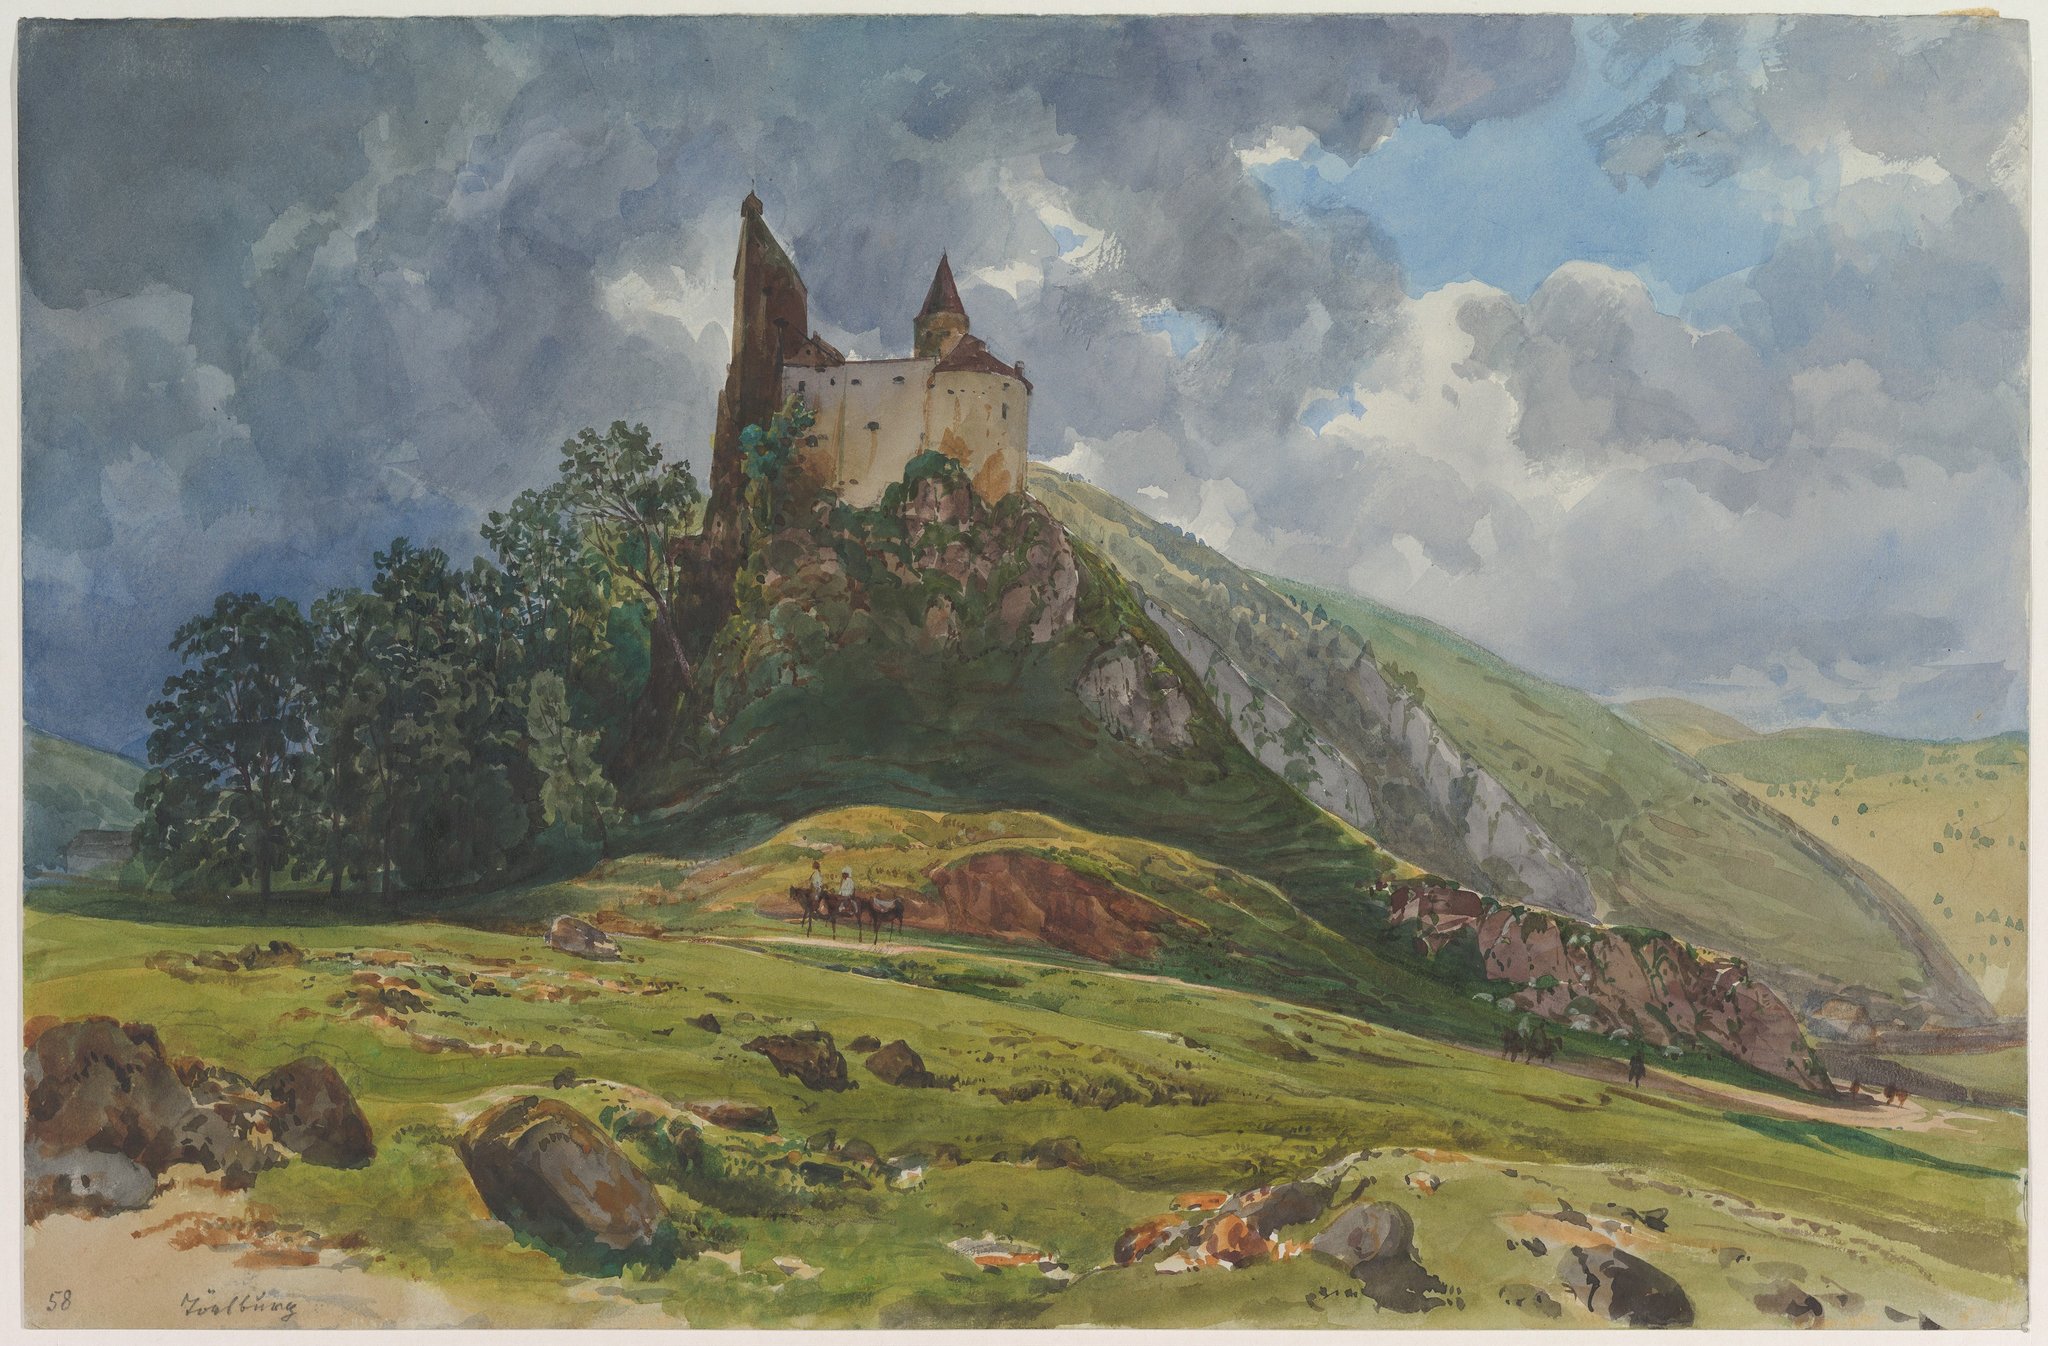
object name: drawing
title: Ruin of Burg Schachenstein at Thörl in Styria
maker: thomas ender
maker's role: artist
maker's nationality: austrian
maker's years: 1793-1875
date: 1834-1866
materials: graphite, watercolor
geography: germany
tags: ruins,sky,hills